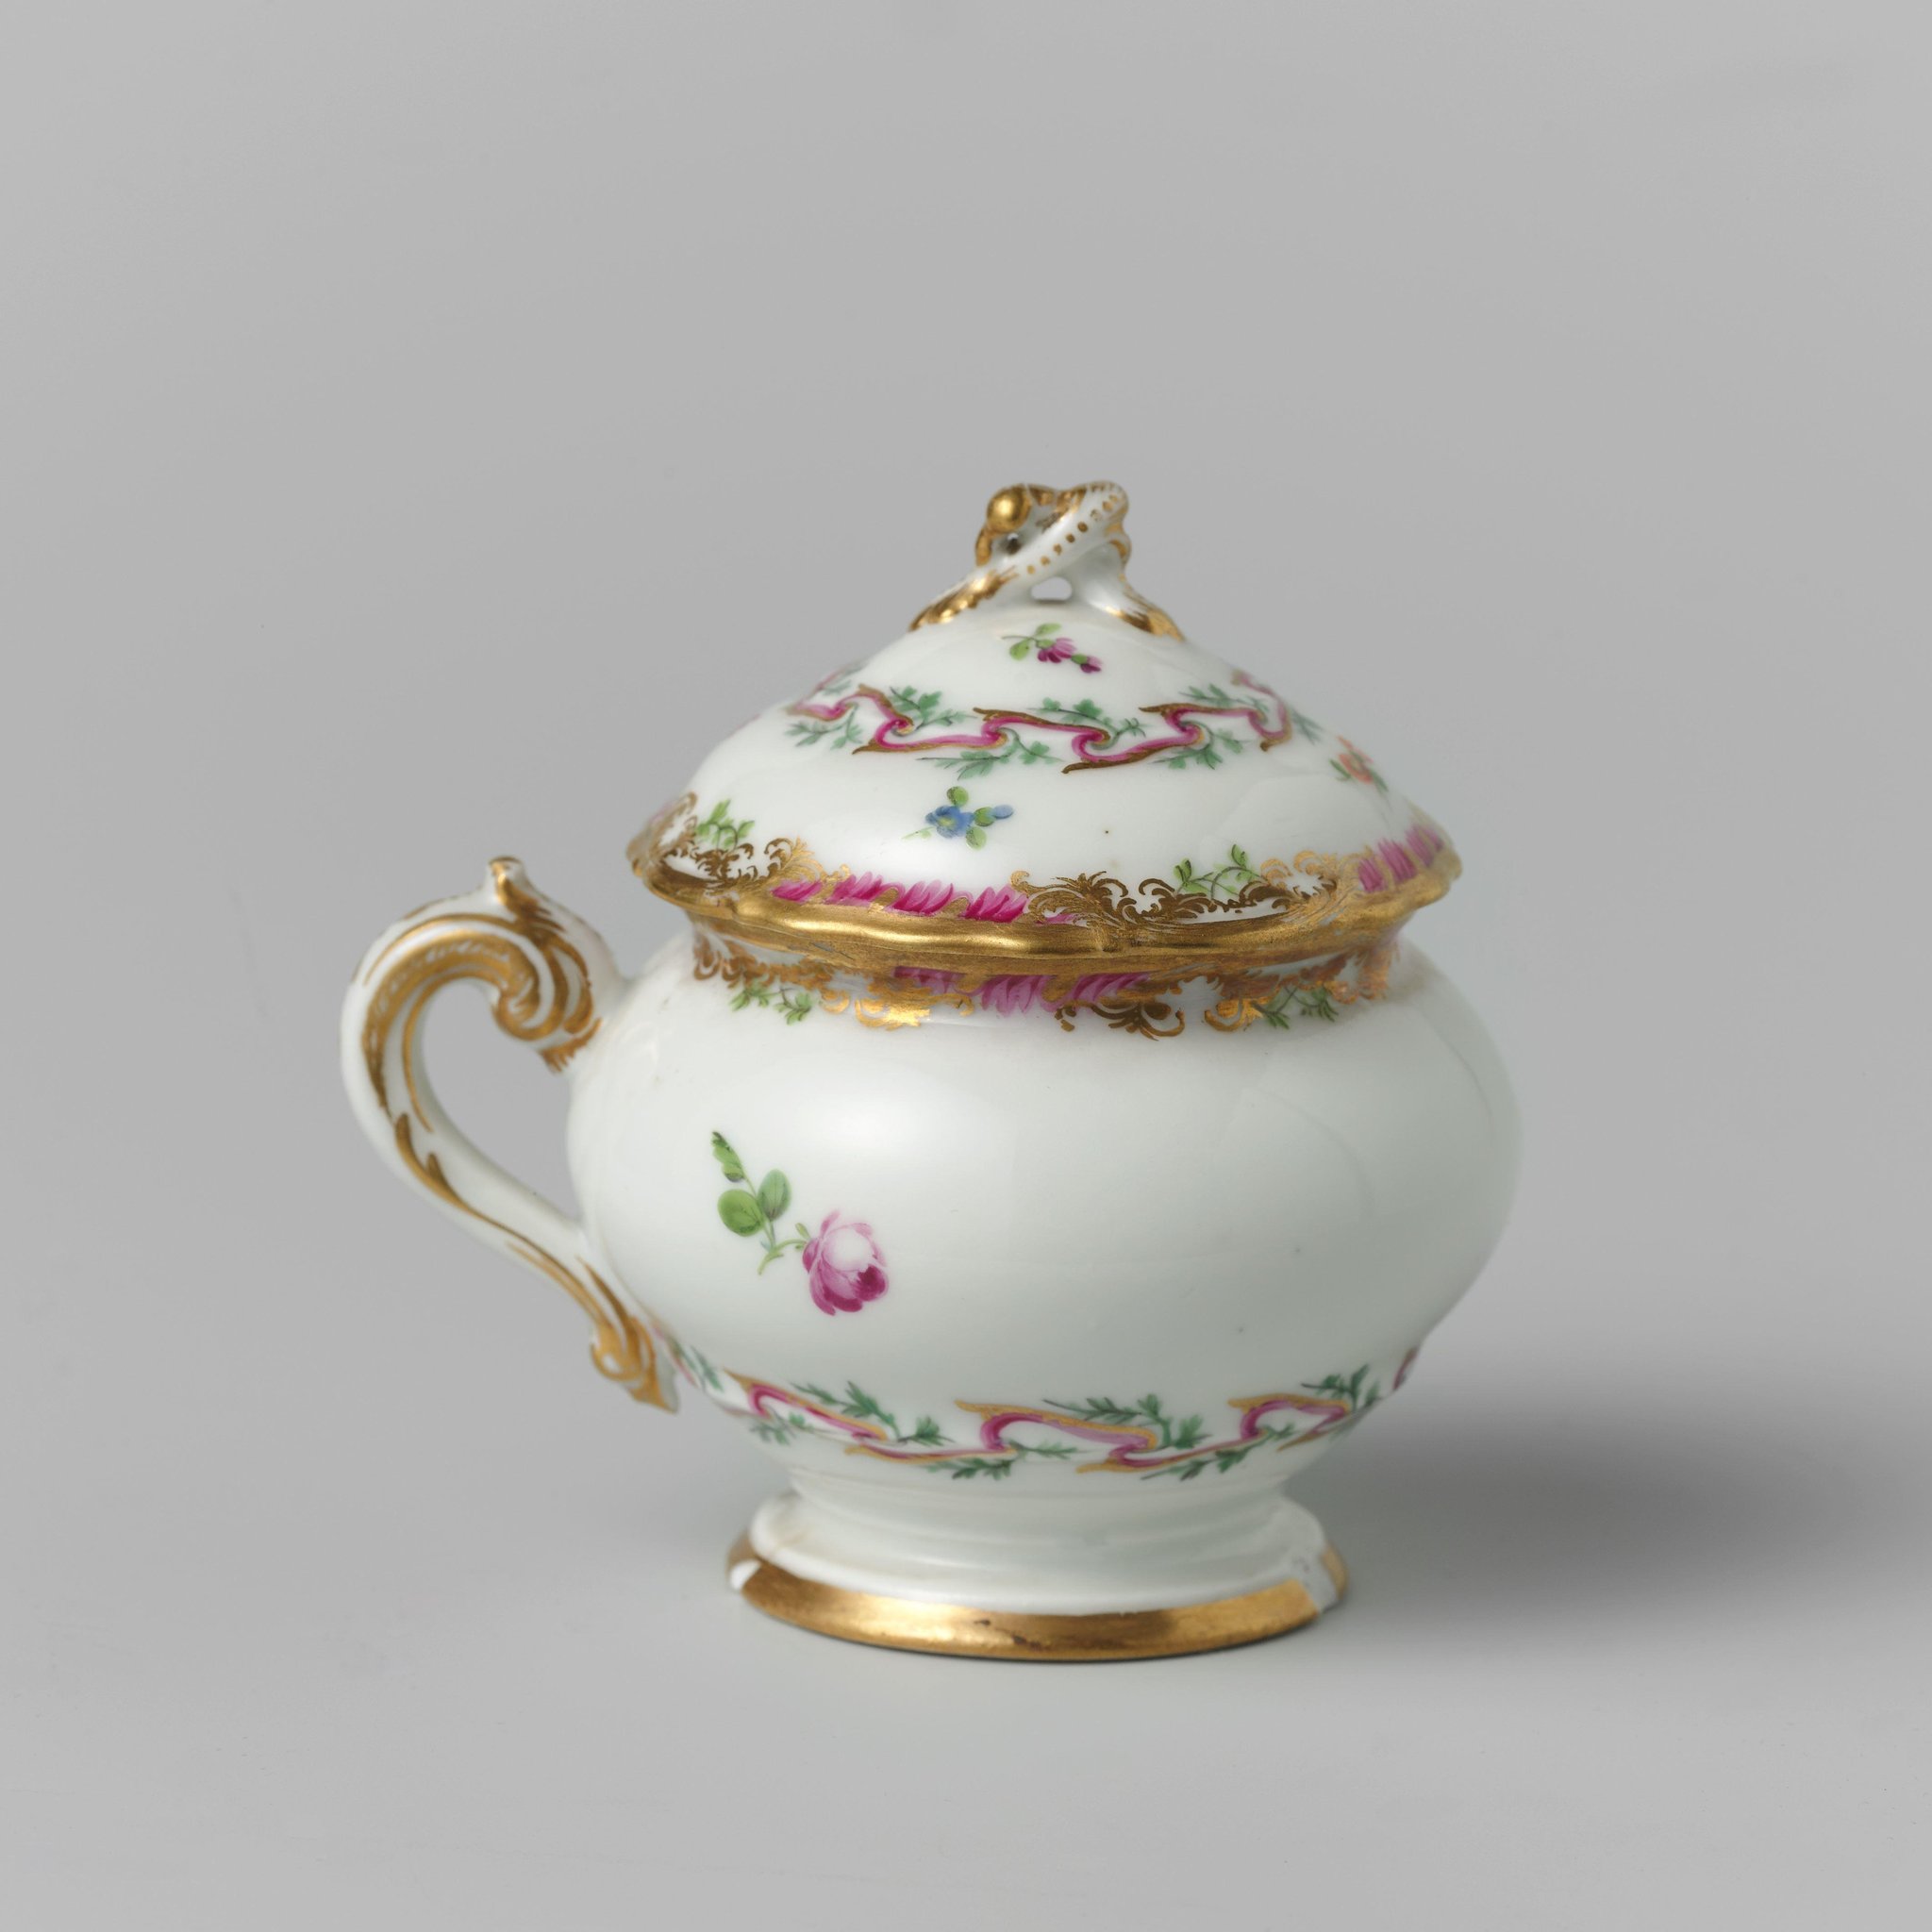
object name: lid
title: Deksel van pasteipot, behorend bij een servies met geslingerd lintmotief met bladertakken, bloemboeketten en gestrooide bloemtakken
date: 1780-1820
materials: porcelain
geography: loosdrecht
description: Deksel van pasteipot, behorend bij een servies van porselein met geslingerd motief in paars en goud met groene bladertakken, bloemboeketten en gestrooide bloemtakken. Randen lichtgegolfd met decoratie in goud met paars bladmotief waartussen groen gekruist bladmotief. Serie van elf stuks.